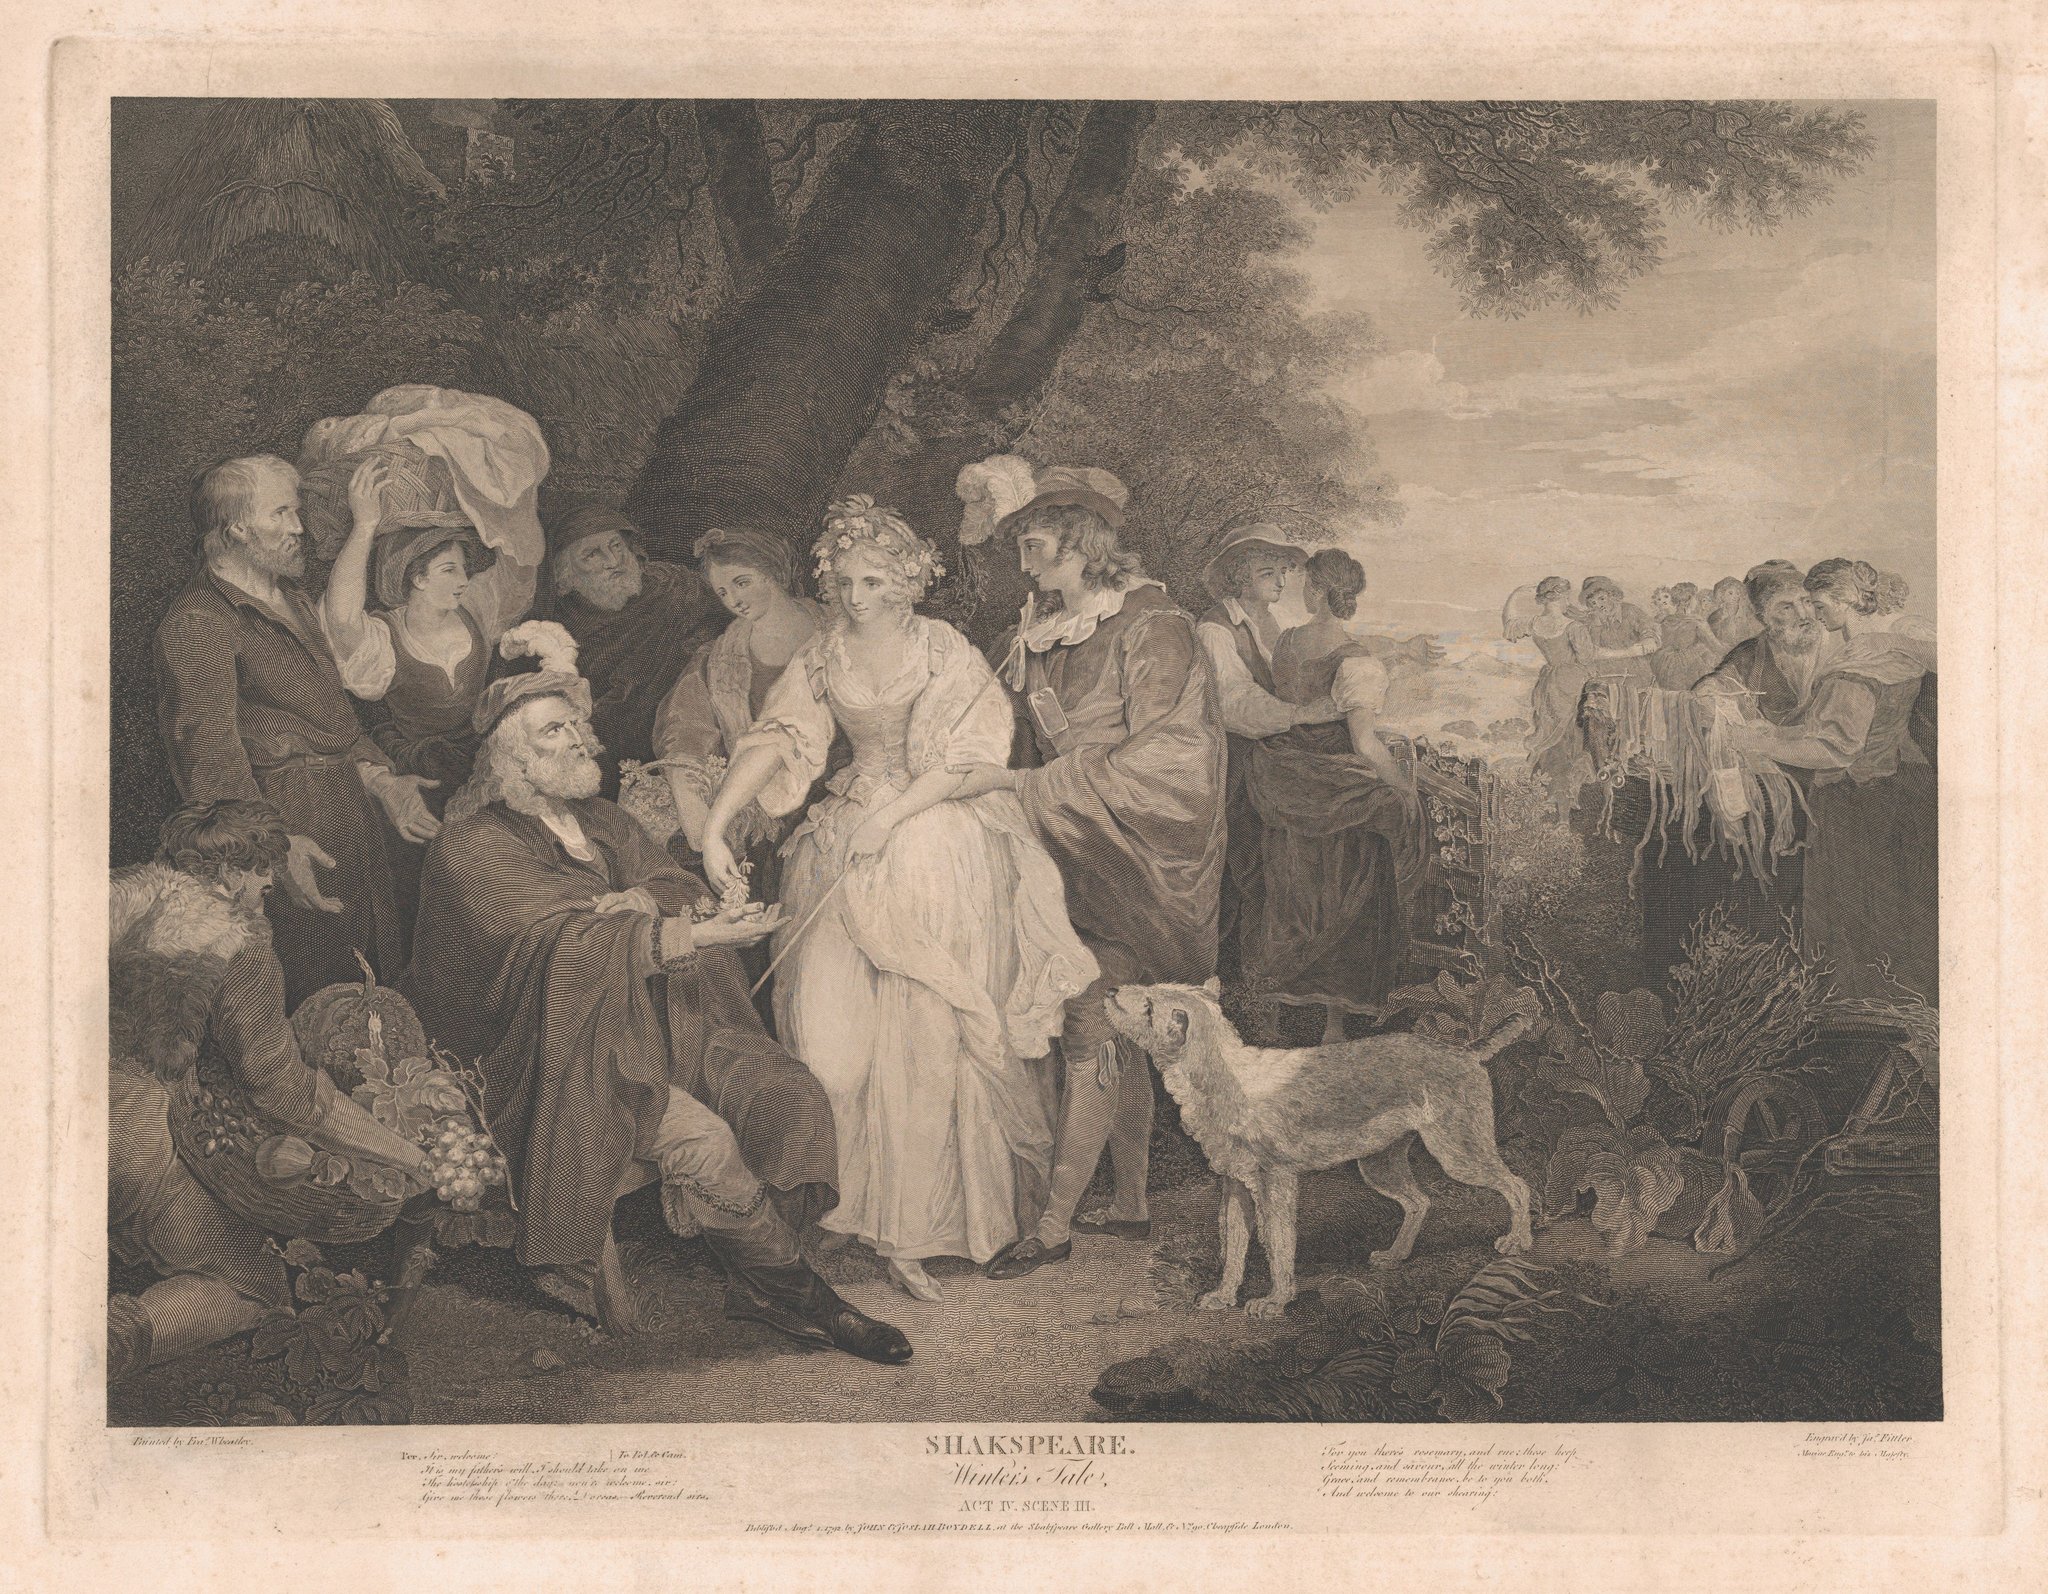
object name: print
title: Florizel, Perdita, etc. in the Shepherd's Cot (Shakespeare, Winter's Tale, Act 4, Scene 3)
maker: james fittler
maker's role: engraver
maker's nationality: british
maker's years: 1758-1835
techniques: engraving, etching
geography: england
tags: fruit,men,women,dancing,dogs,landscapes,trees